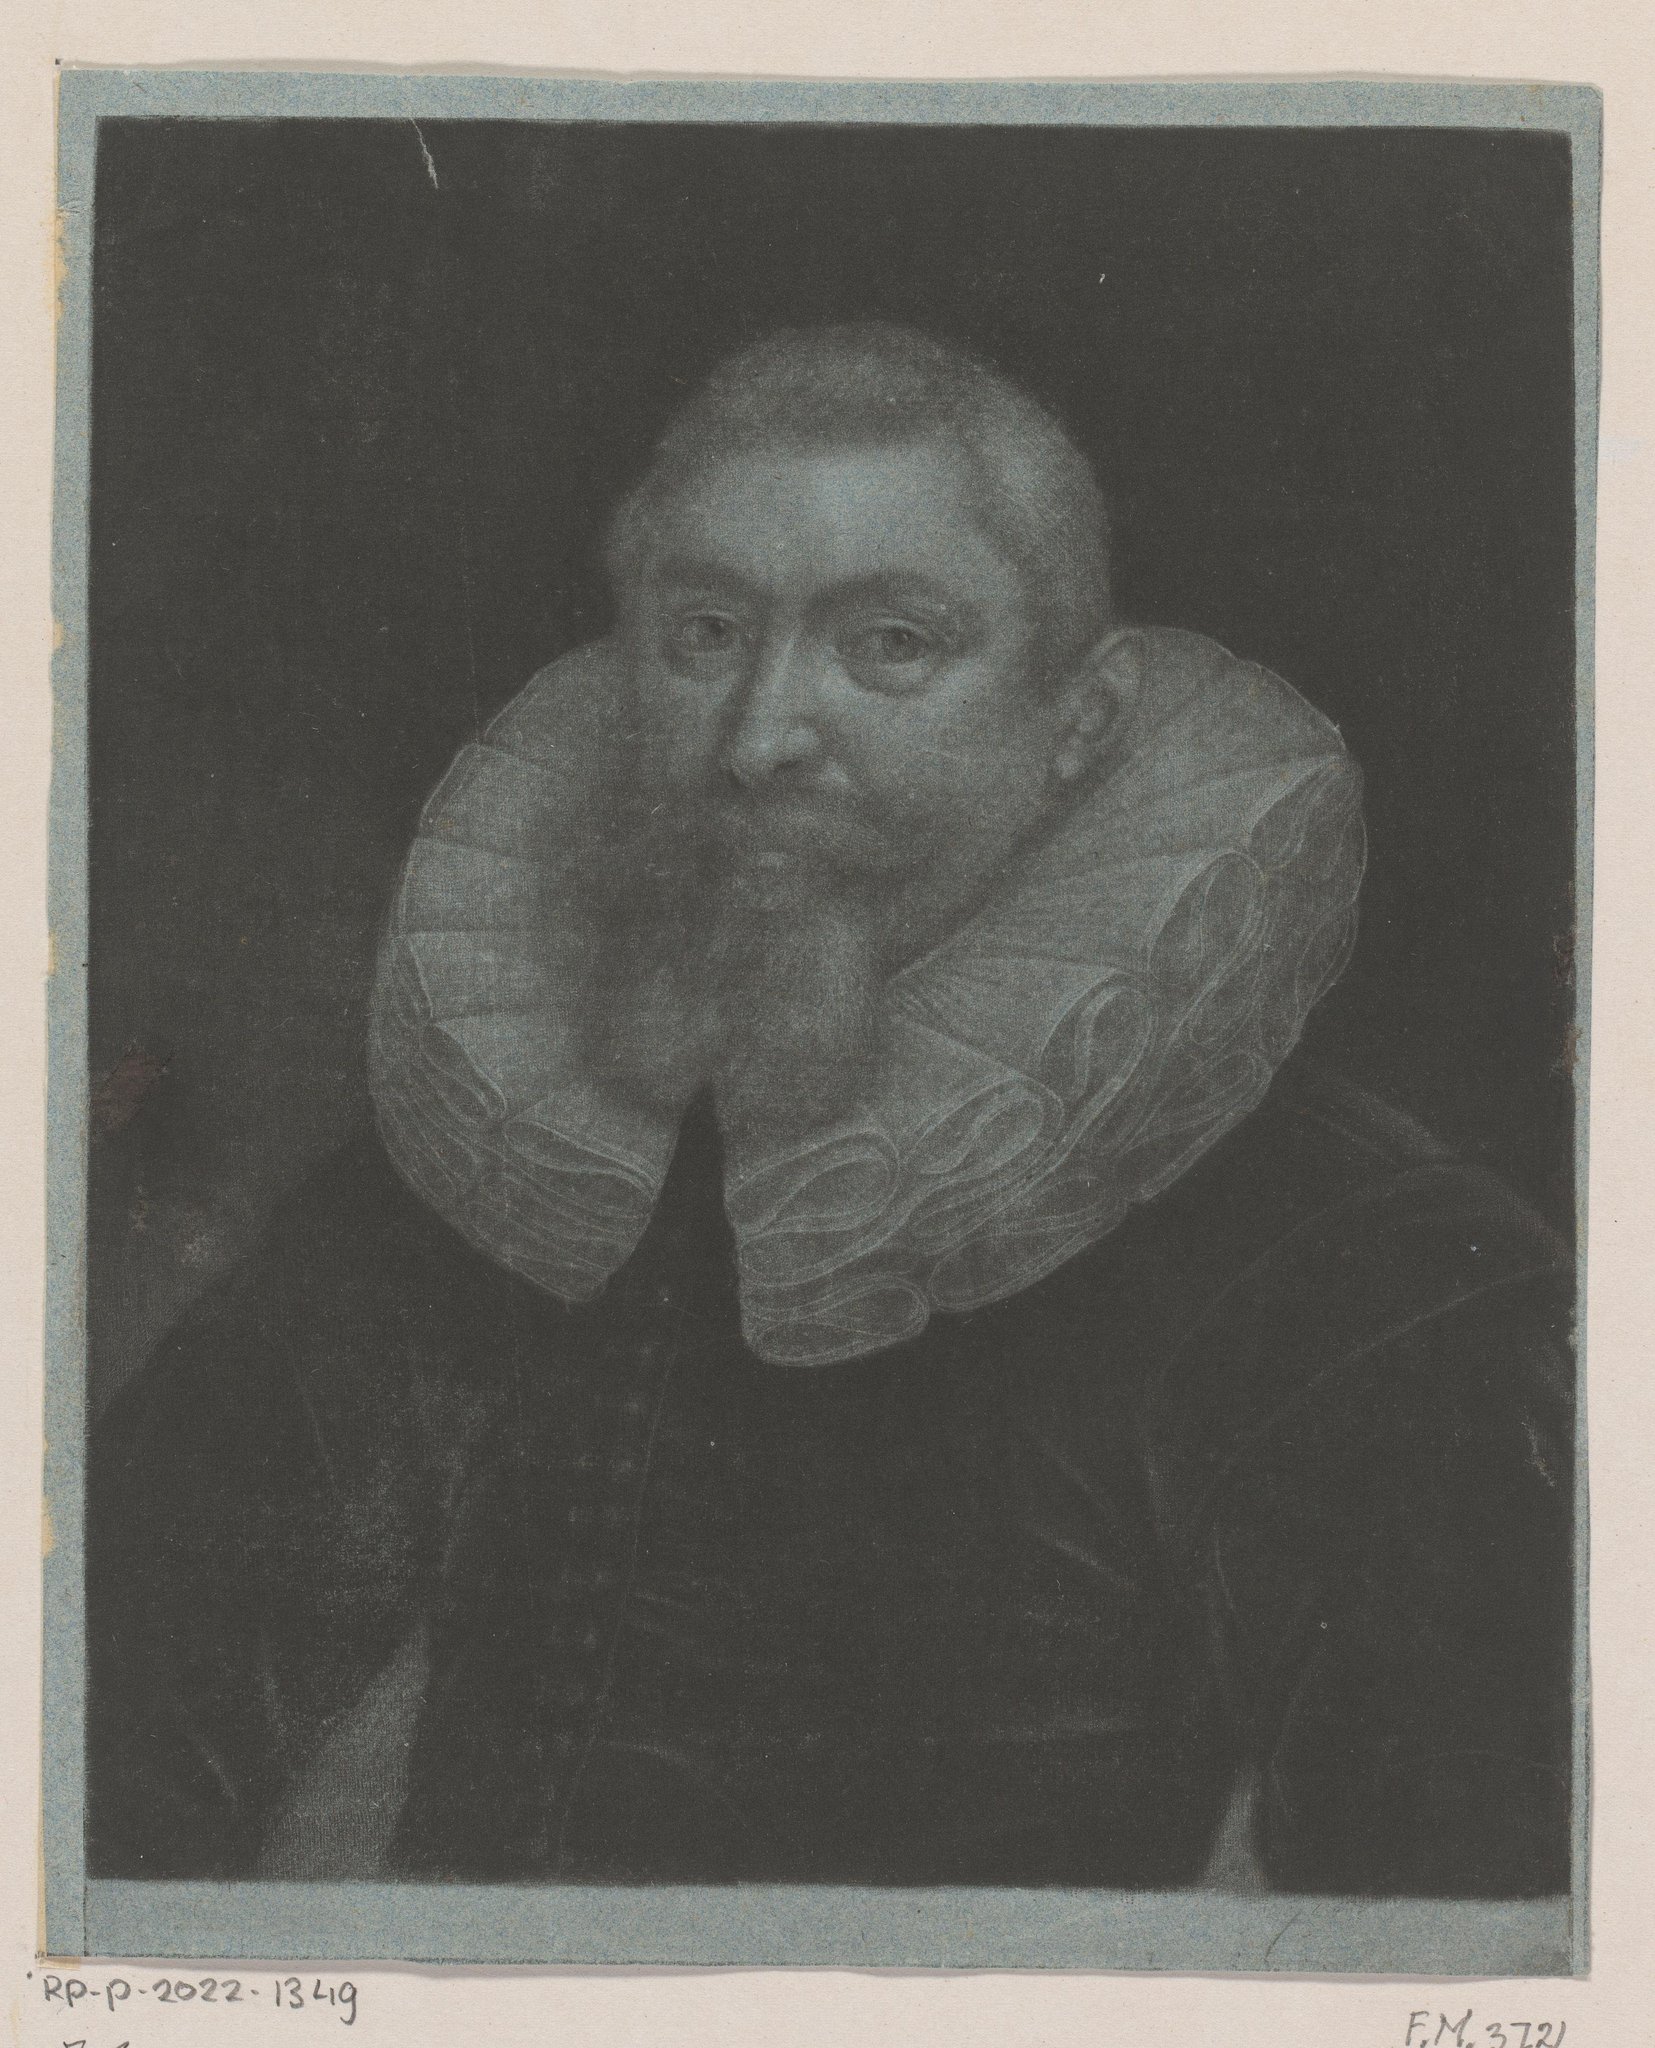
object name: print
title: Portret van Joos de Moor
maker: Anonymous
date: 1750-1853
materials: paper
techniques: mezzotint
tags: flushing, historical persons, commander-in-chief, admiral